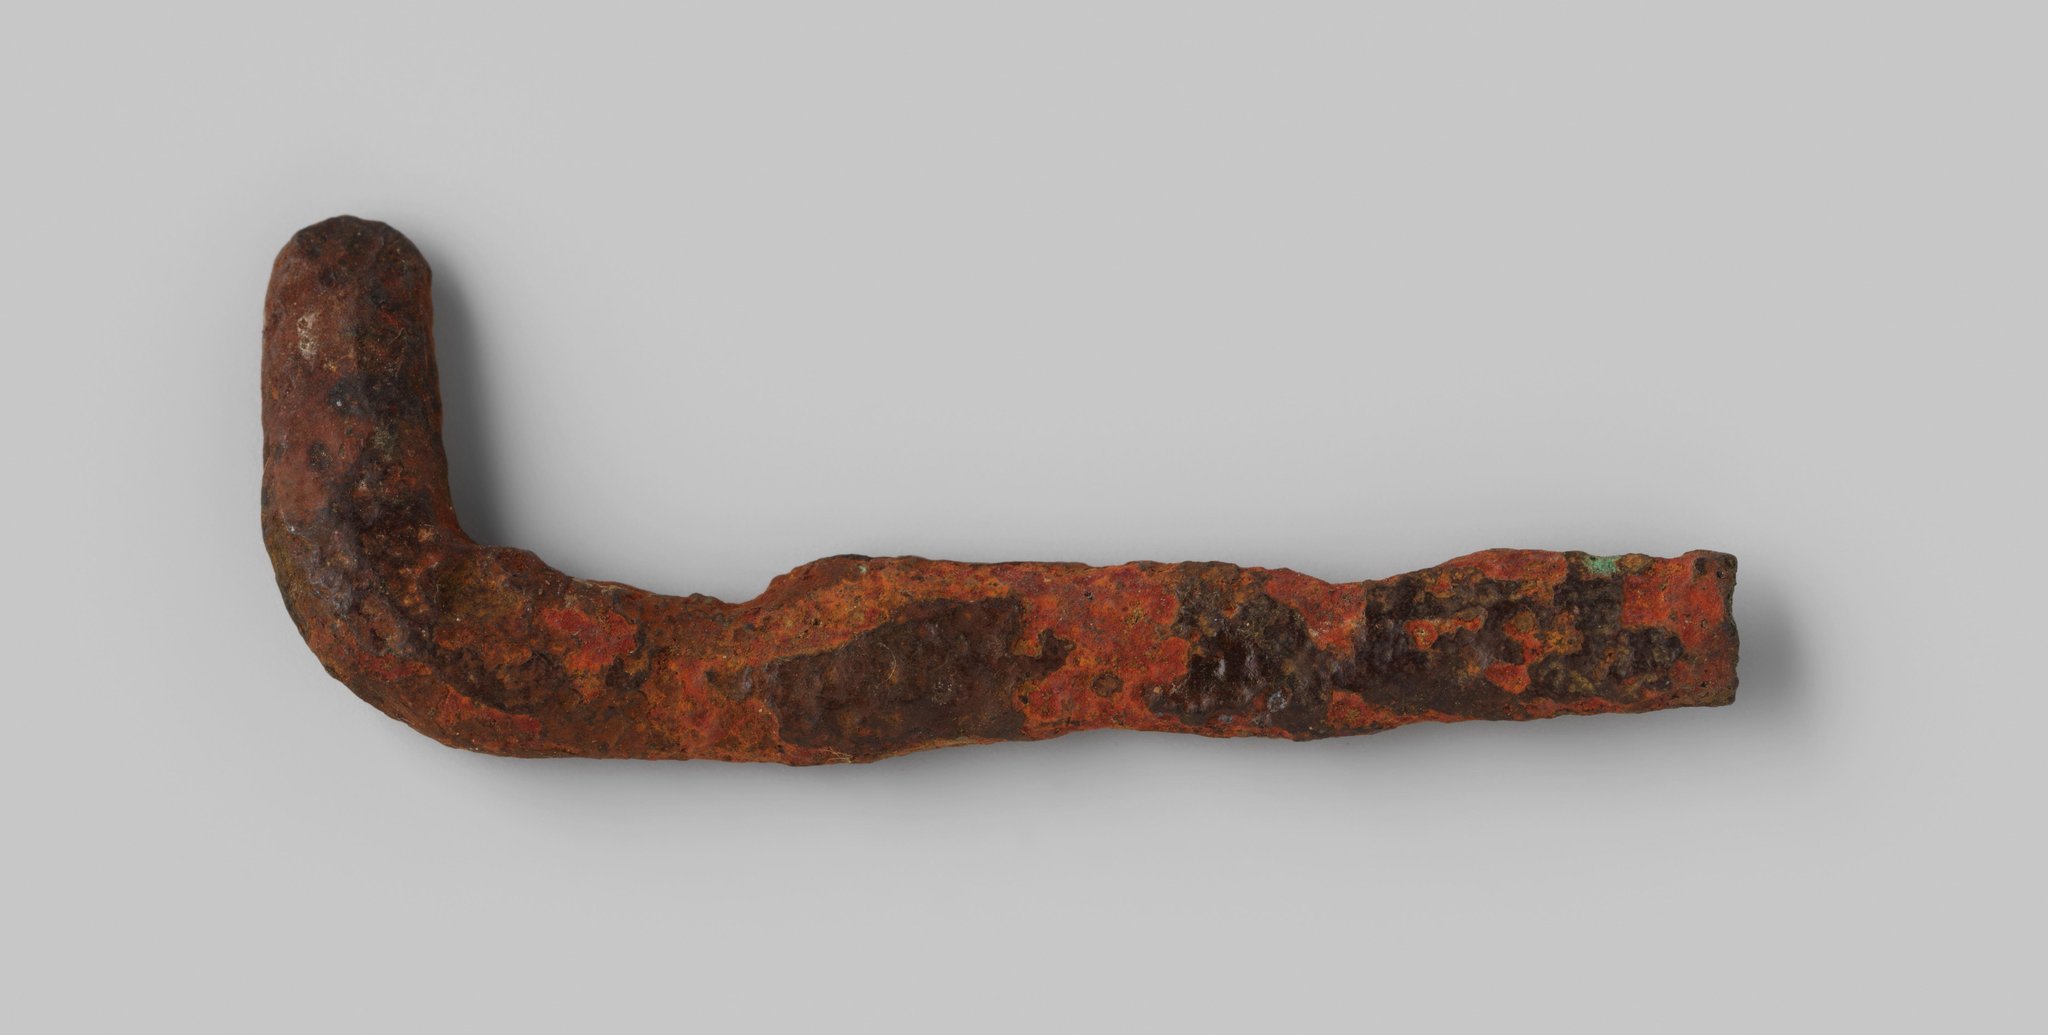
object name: belt buckle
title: Fragment riemgesp uit het wrak van de Oost-Indiëvaarder Hollandia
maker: Anonymous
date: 1700-1743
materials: copper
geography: netherlands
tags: verenigde oostindische compagnie, hollandia (schip), annet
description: Rectangular, fragm of ring, NG 1980-27H2796, belt buckle.